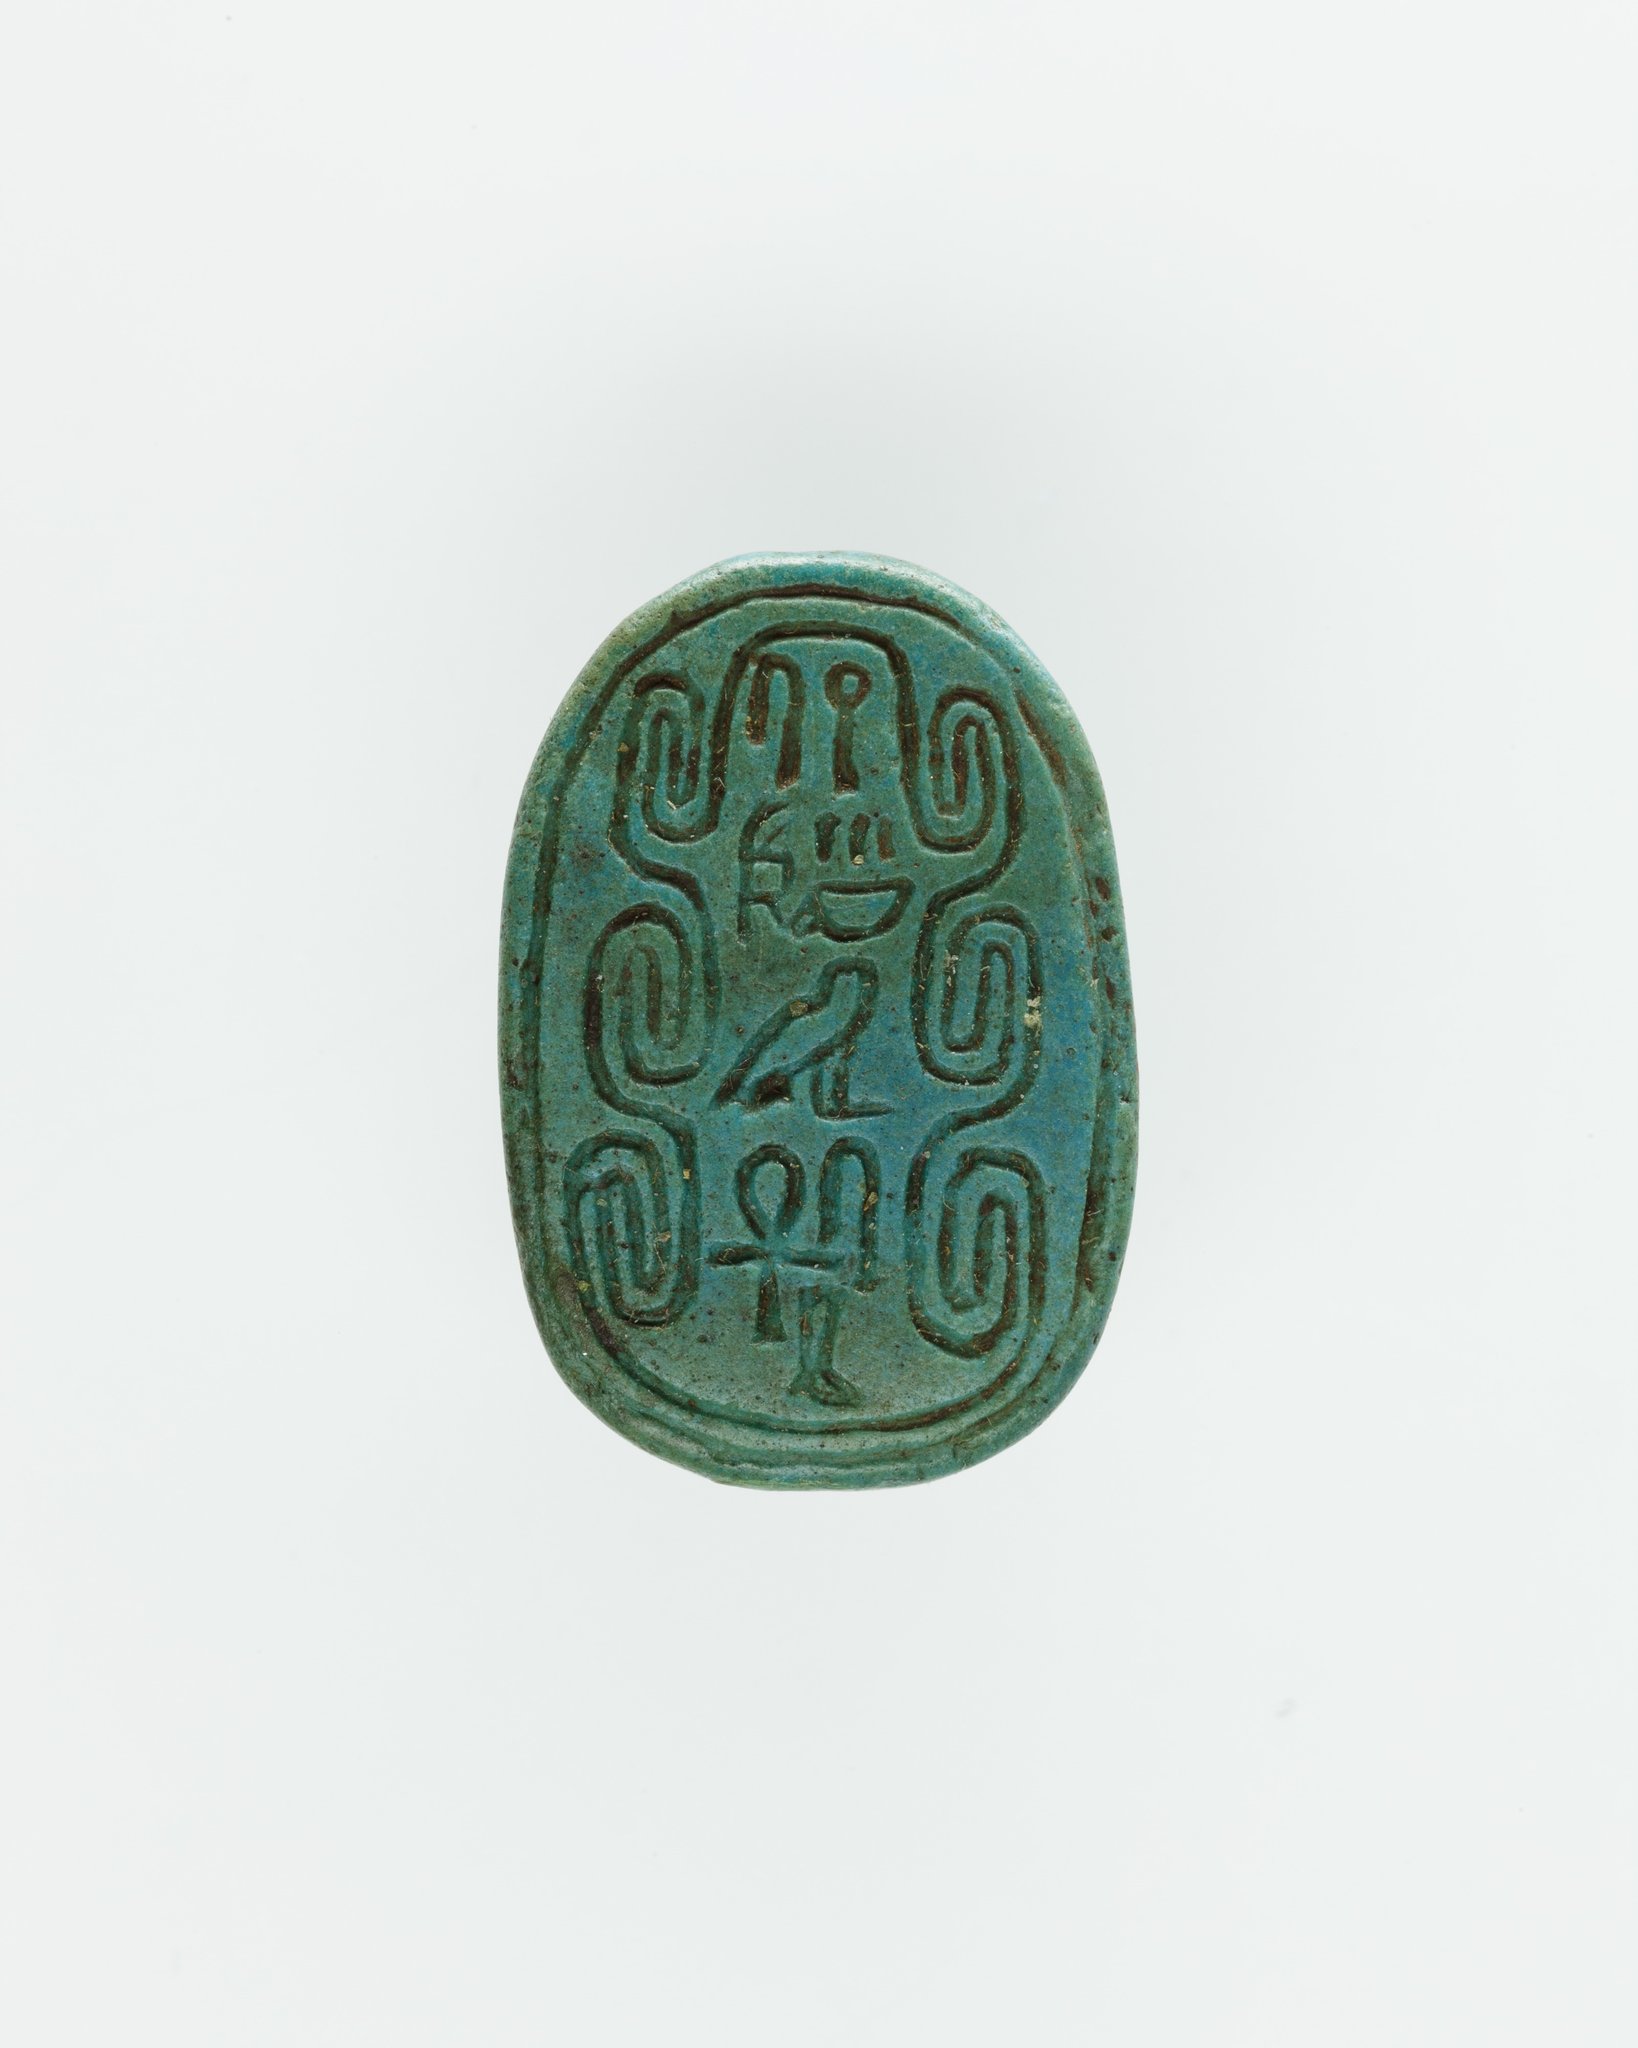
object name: scarab, private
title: Scarab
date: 1850-1640 BCE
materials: stone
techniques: glazing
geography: egypt